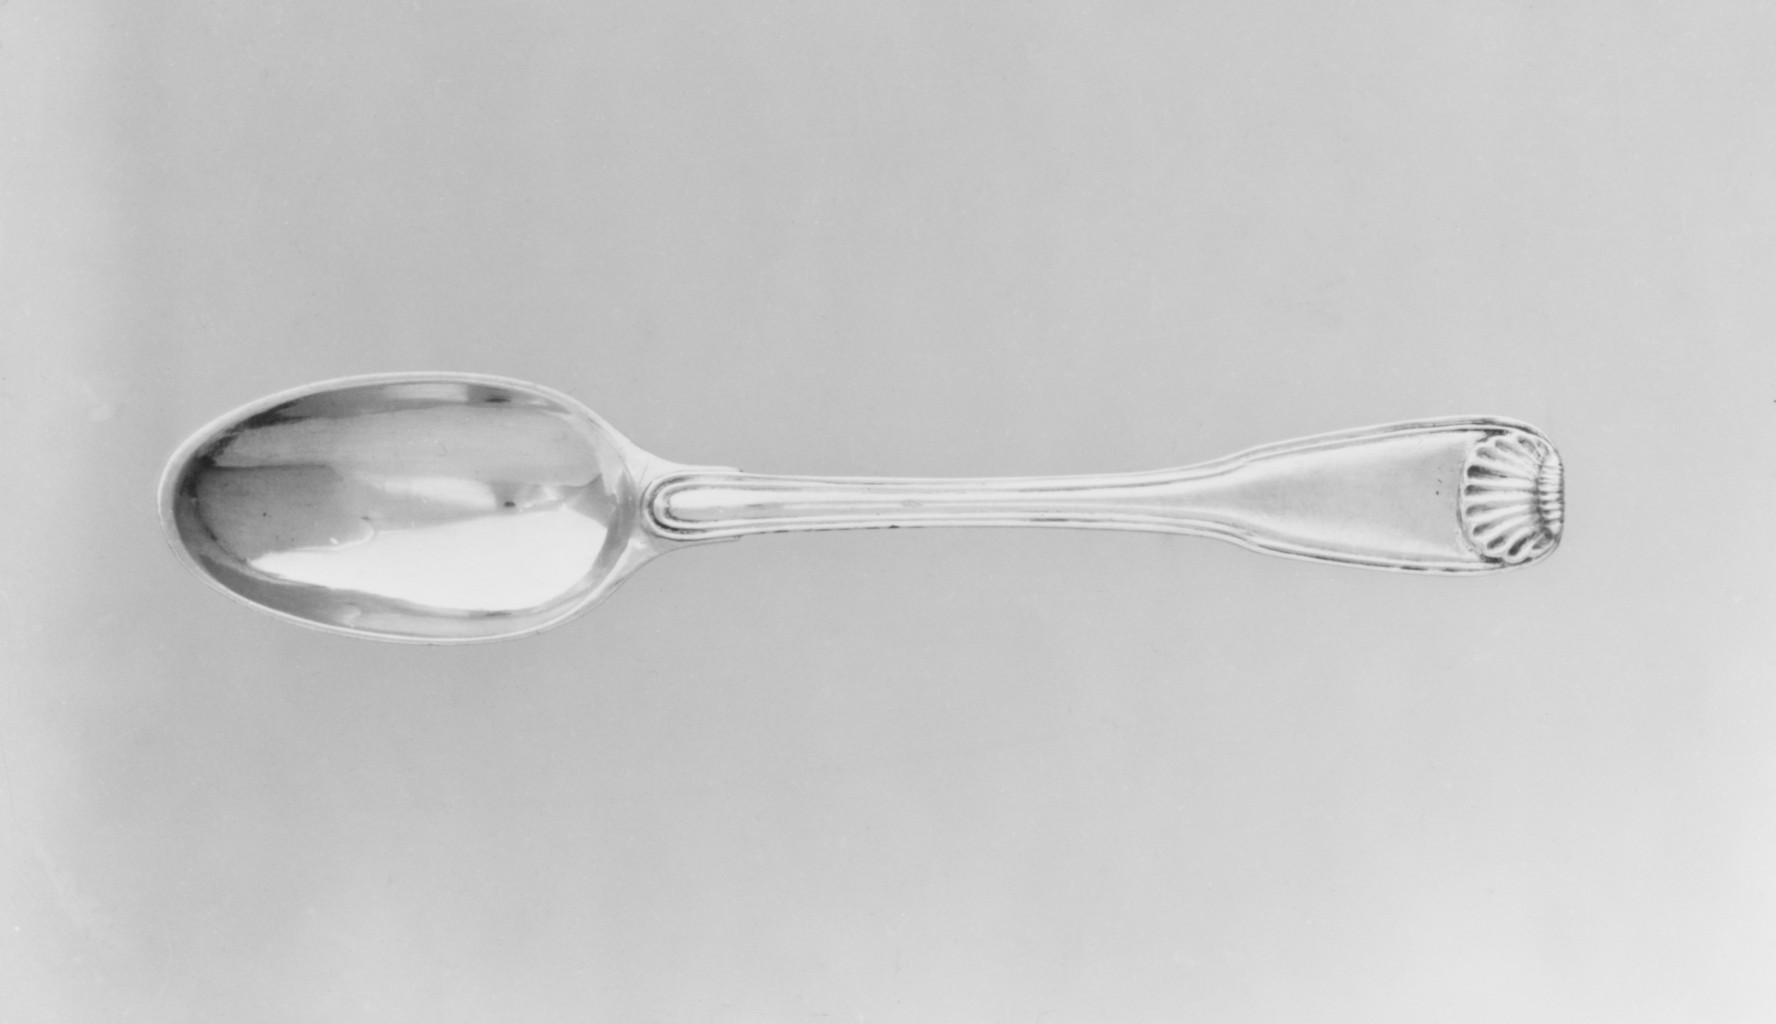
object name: spoon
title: Spoon (one of three)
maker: jean-henri oertel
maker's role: maker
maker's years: 1733-1812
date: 1763-1789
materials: silver gilt